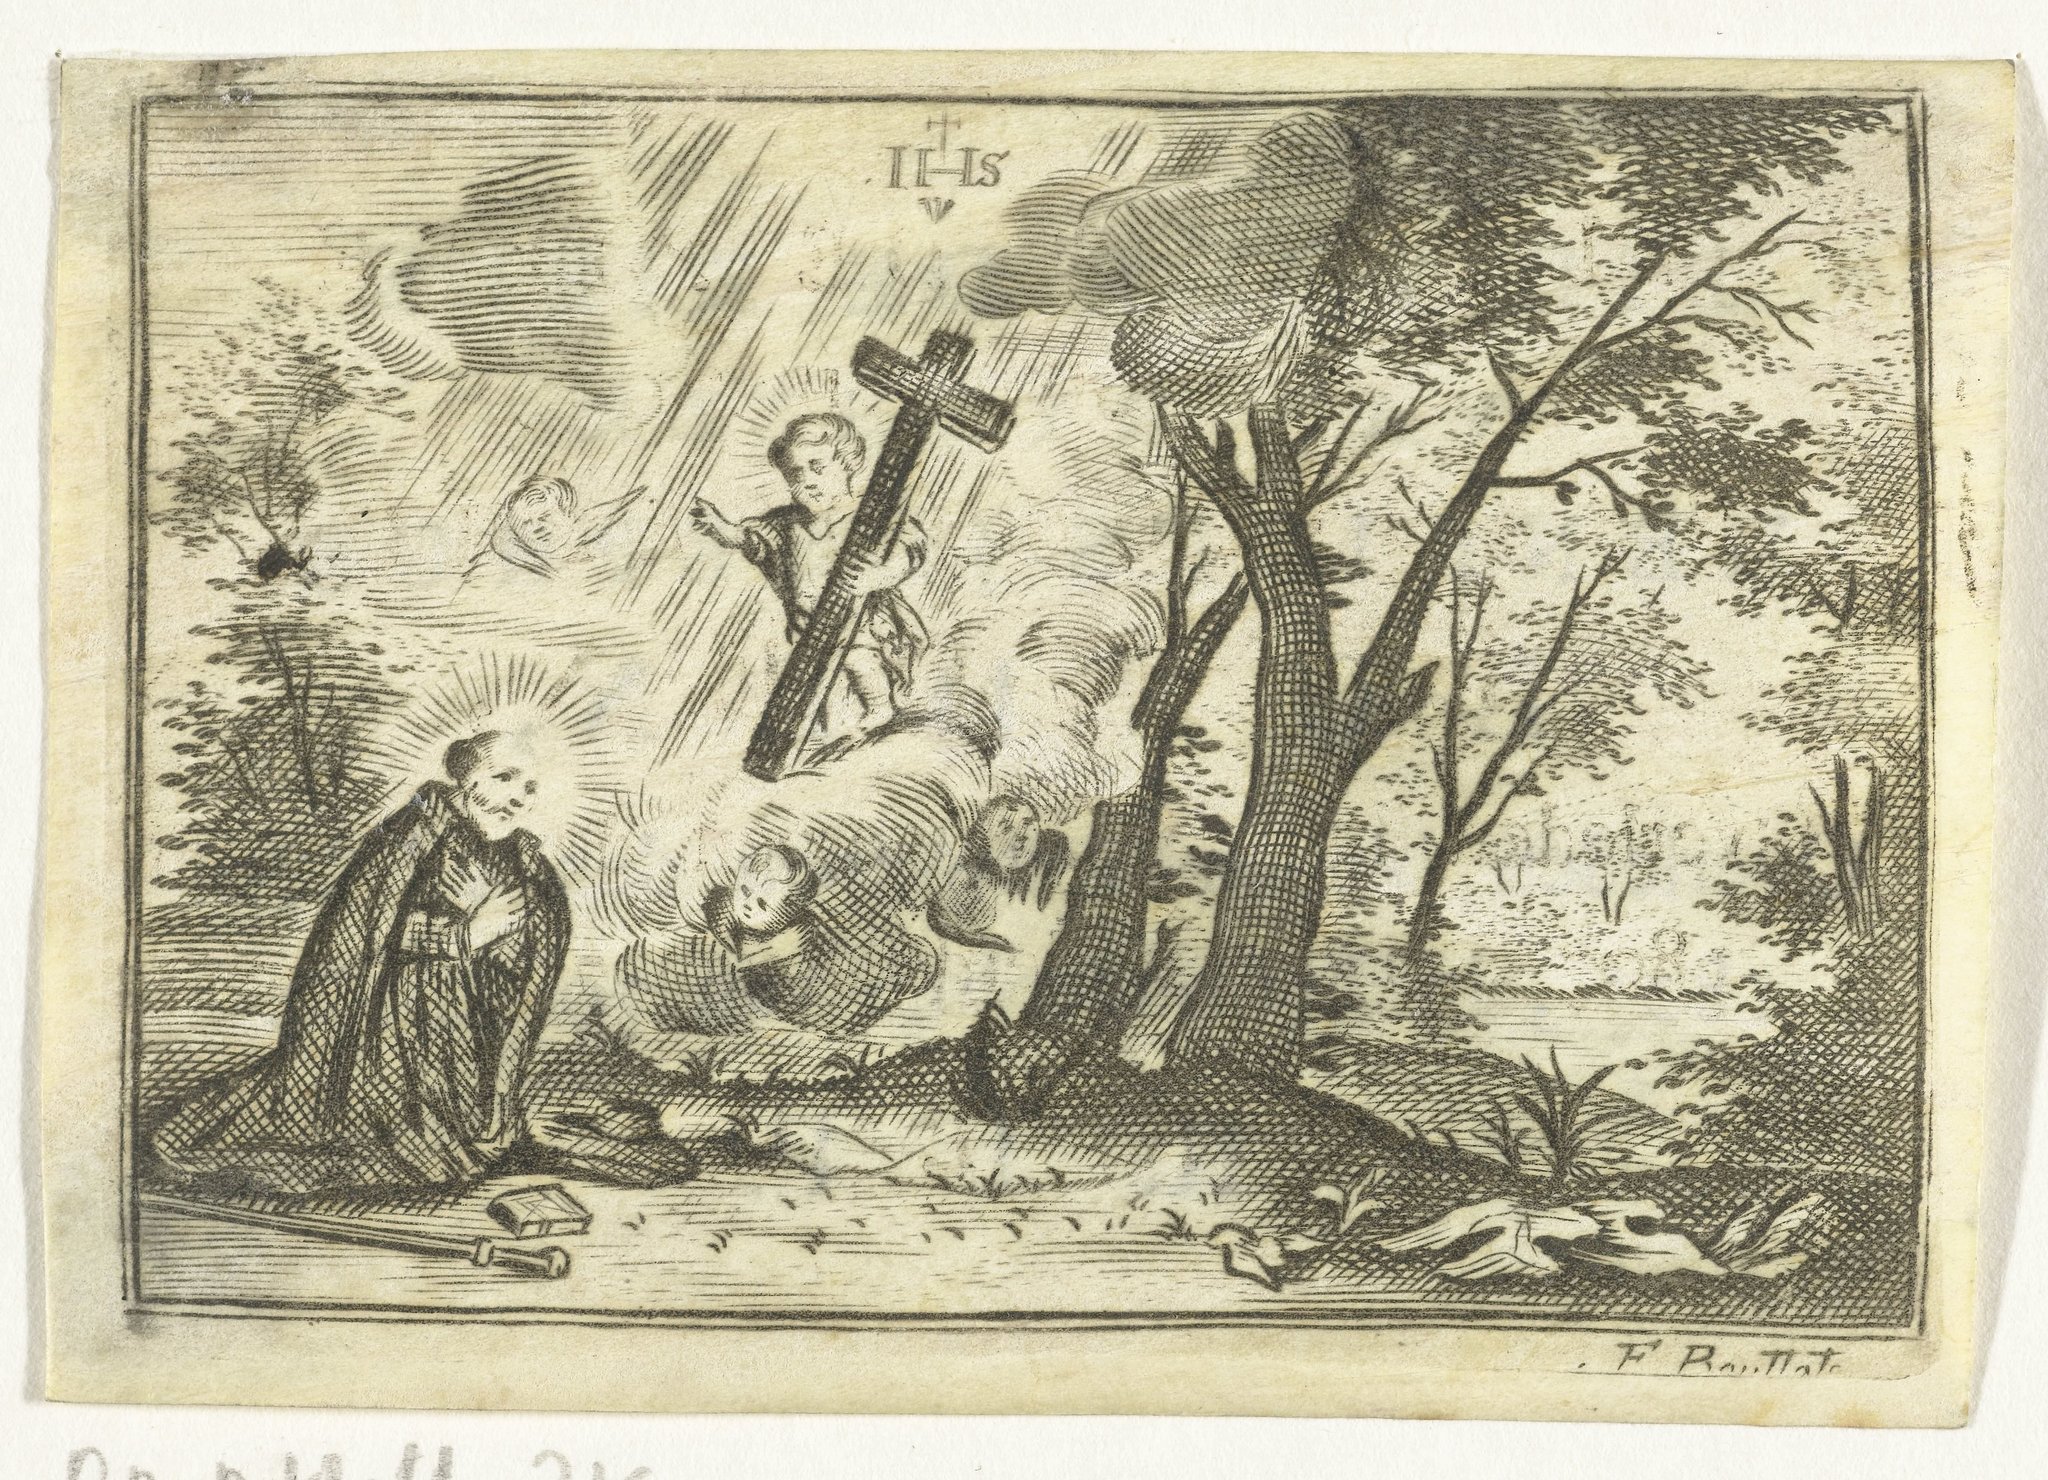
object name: print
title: Heilige met visioen van Christus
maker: frederik bouttats (i)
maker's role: artist, painter, print maker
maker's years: 1590-1661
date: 1600-1661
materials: paper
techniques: engraving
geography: antwerp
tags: regular clerics, e.g. jesuits, redemptorists, vision, christ-child carrying the cross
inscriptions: collector's mark: Lugt 2228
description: Een niet nader te identificeren Heilige (waarschijnlijk van de orde van Jezuïeten) ontvangt in een bosrijke omgeving een visioen van Christus. Hij knielt en vouwt zijn handen voor zijn borst terwijl uit de wolken openbreken en het Christuskind met het kruis in zijn handen aan hem verschijnt. Rond de wolken vliegen cherubijnen. Boven in de wolken het monogram van Christus (IHS). Op het verso een bidprentje uit 1807 voor Henricus-Josephus Lunden uit Antwerpen